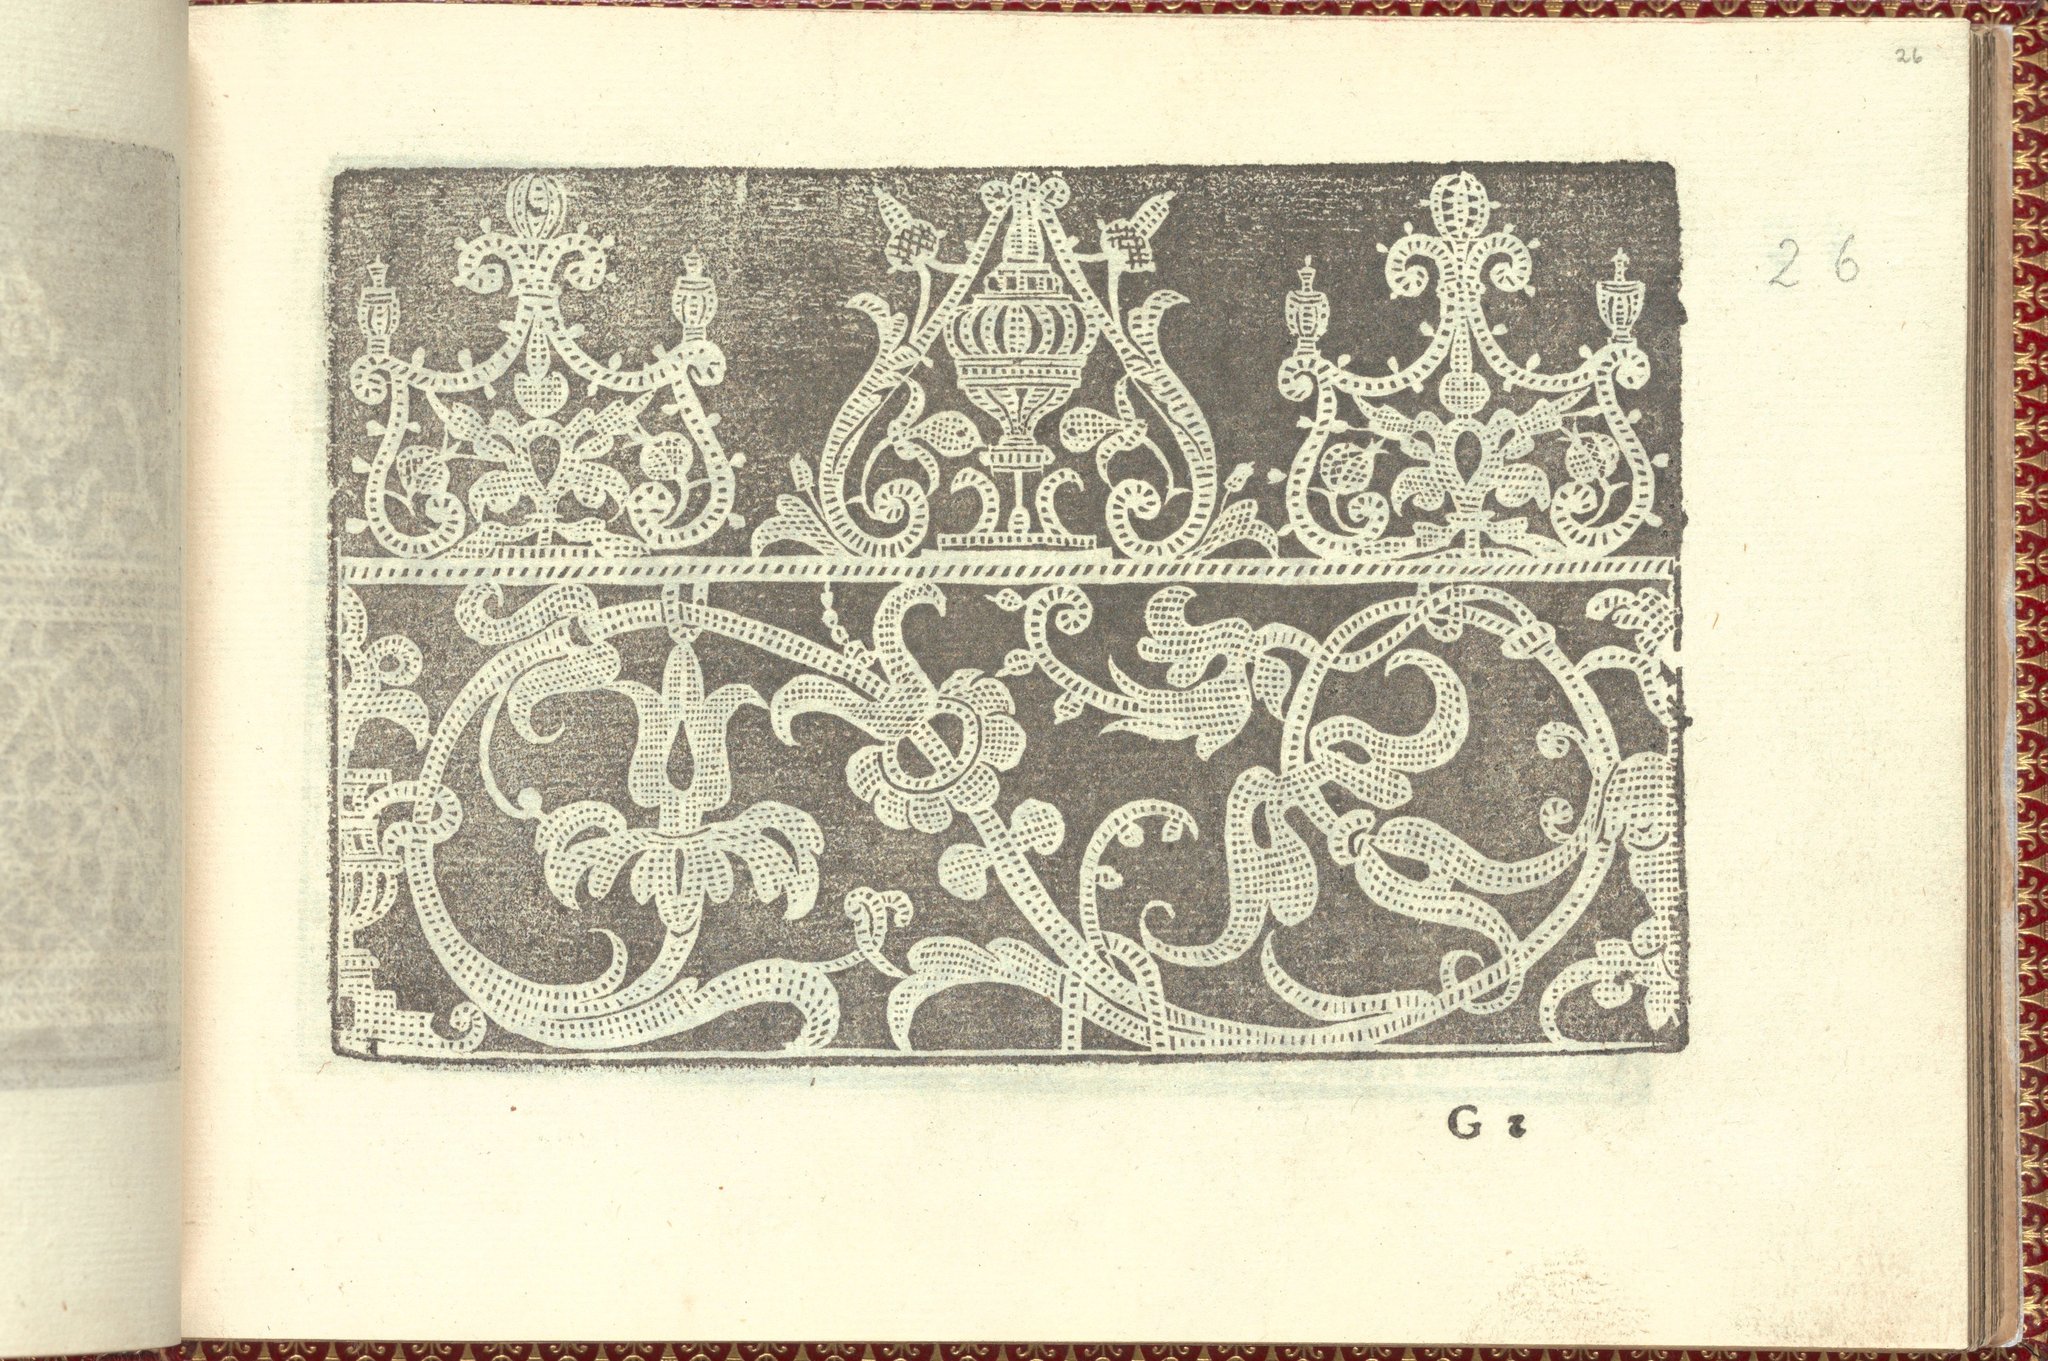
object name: book print ornament architecture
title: Corona delle Nobili et Virtuose Donne: Libro I-IV, page 26 (recto)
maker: cesare vecellio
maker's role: publisher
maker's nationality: italian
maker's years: 1521-1601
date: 1601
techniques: woodcut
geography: italy